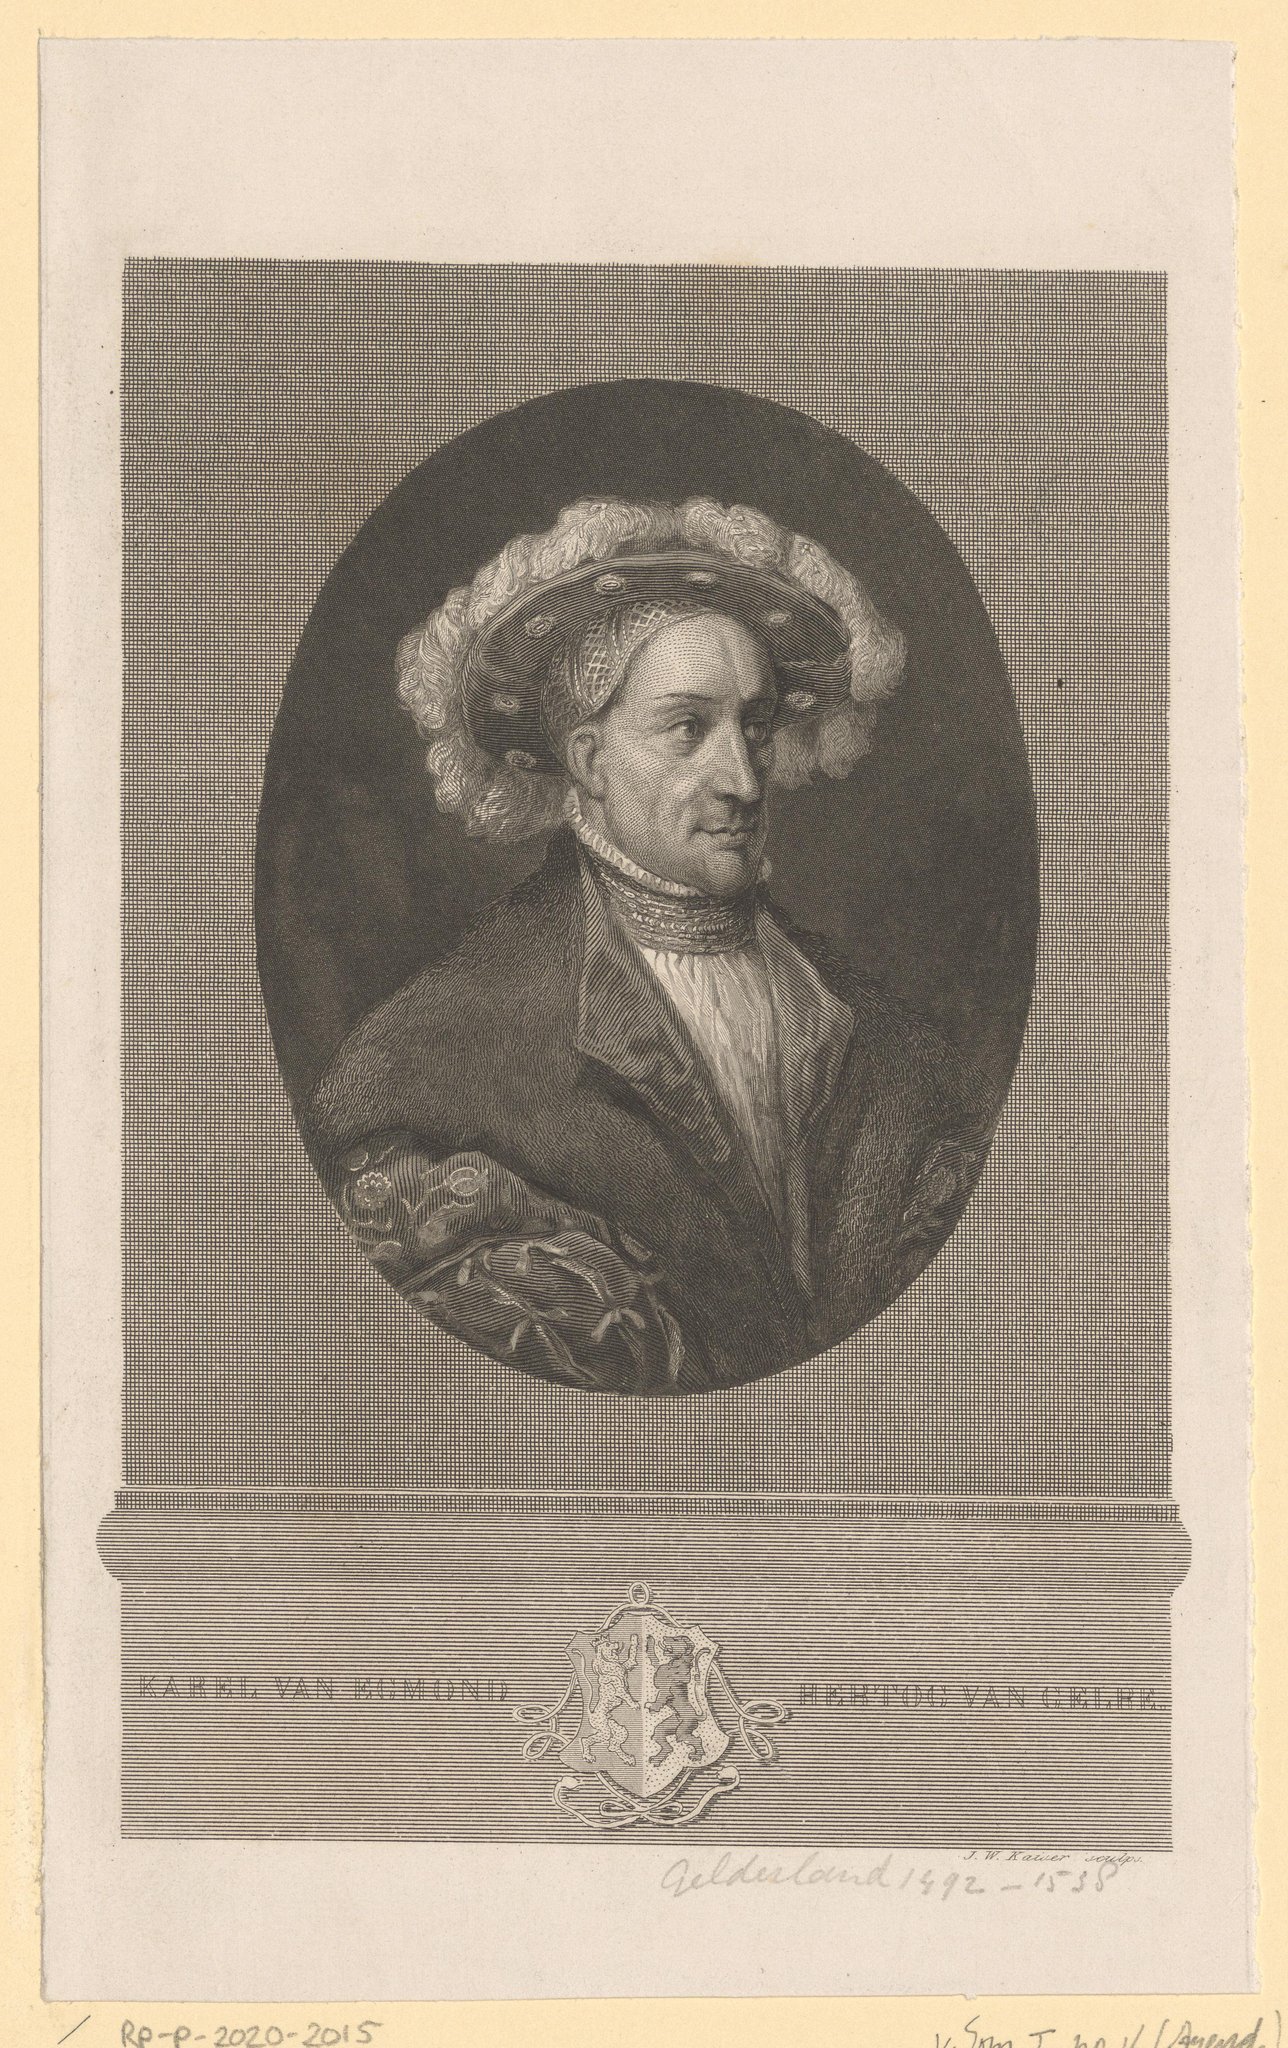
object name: book illustration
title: Portret van Karel van Egmond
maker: johann wilhelm kaiser (i)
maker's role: draughtsman, print maker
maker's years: 1813-1900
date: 1846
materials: paper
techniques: engraving, etching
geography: netherlands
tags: grave, earl, karel van egmond, historical persons, head-gear (+ feathers used for clothes)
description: Prent waarschijnlijk uit: Arend, Johannes Pieter. Algemeene geschiedenis des vaderlands van de vroegste tijden tot op heden. Amsterdam: Schleijer, J.F, 1846, dl 2-3, p. 662. Prent mogelijk ook gebruikt in latere edities.